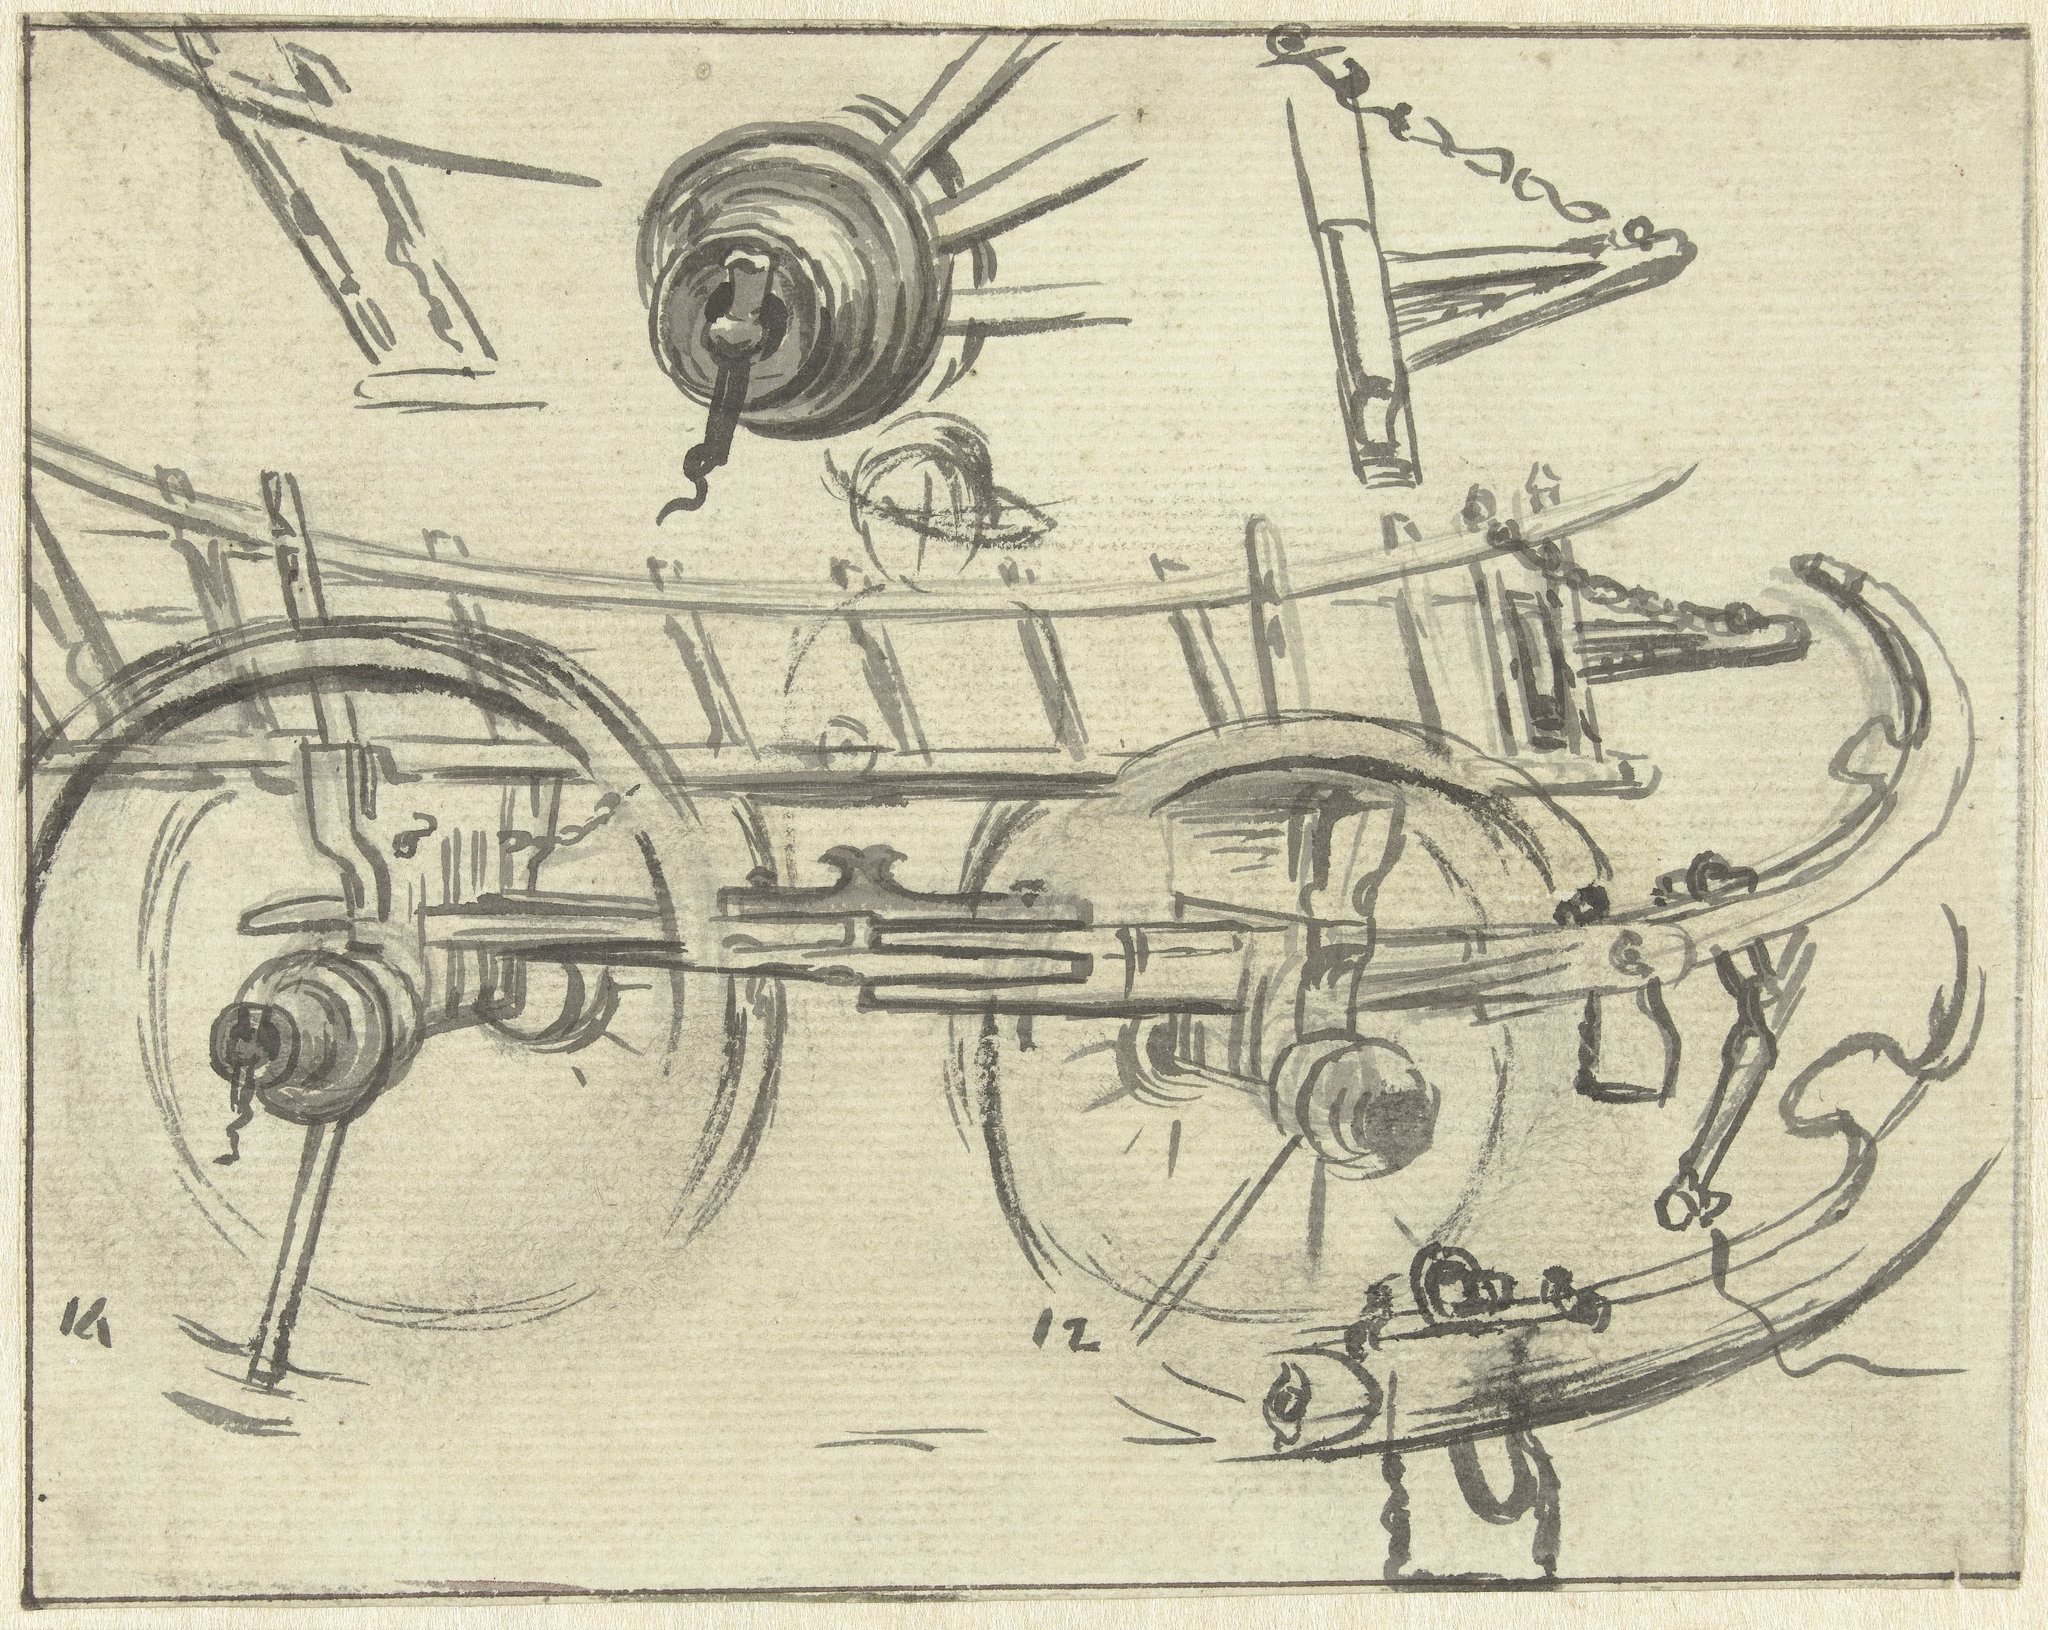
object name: watercolor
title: Onderdelen van de constructie van een boerenwagen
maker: simon andreas krausz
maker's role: draughtsman, print maker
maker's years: 1760-1825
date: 1770-1825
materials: paper, watercolor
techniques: brush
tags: (farm) wagon, freight wagon, cart